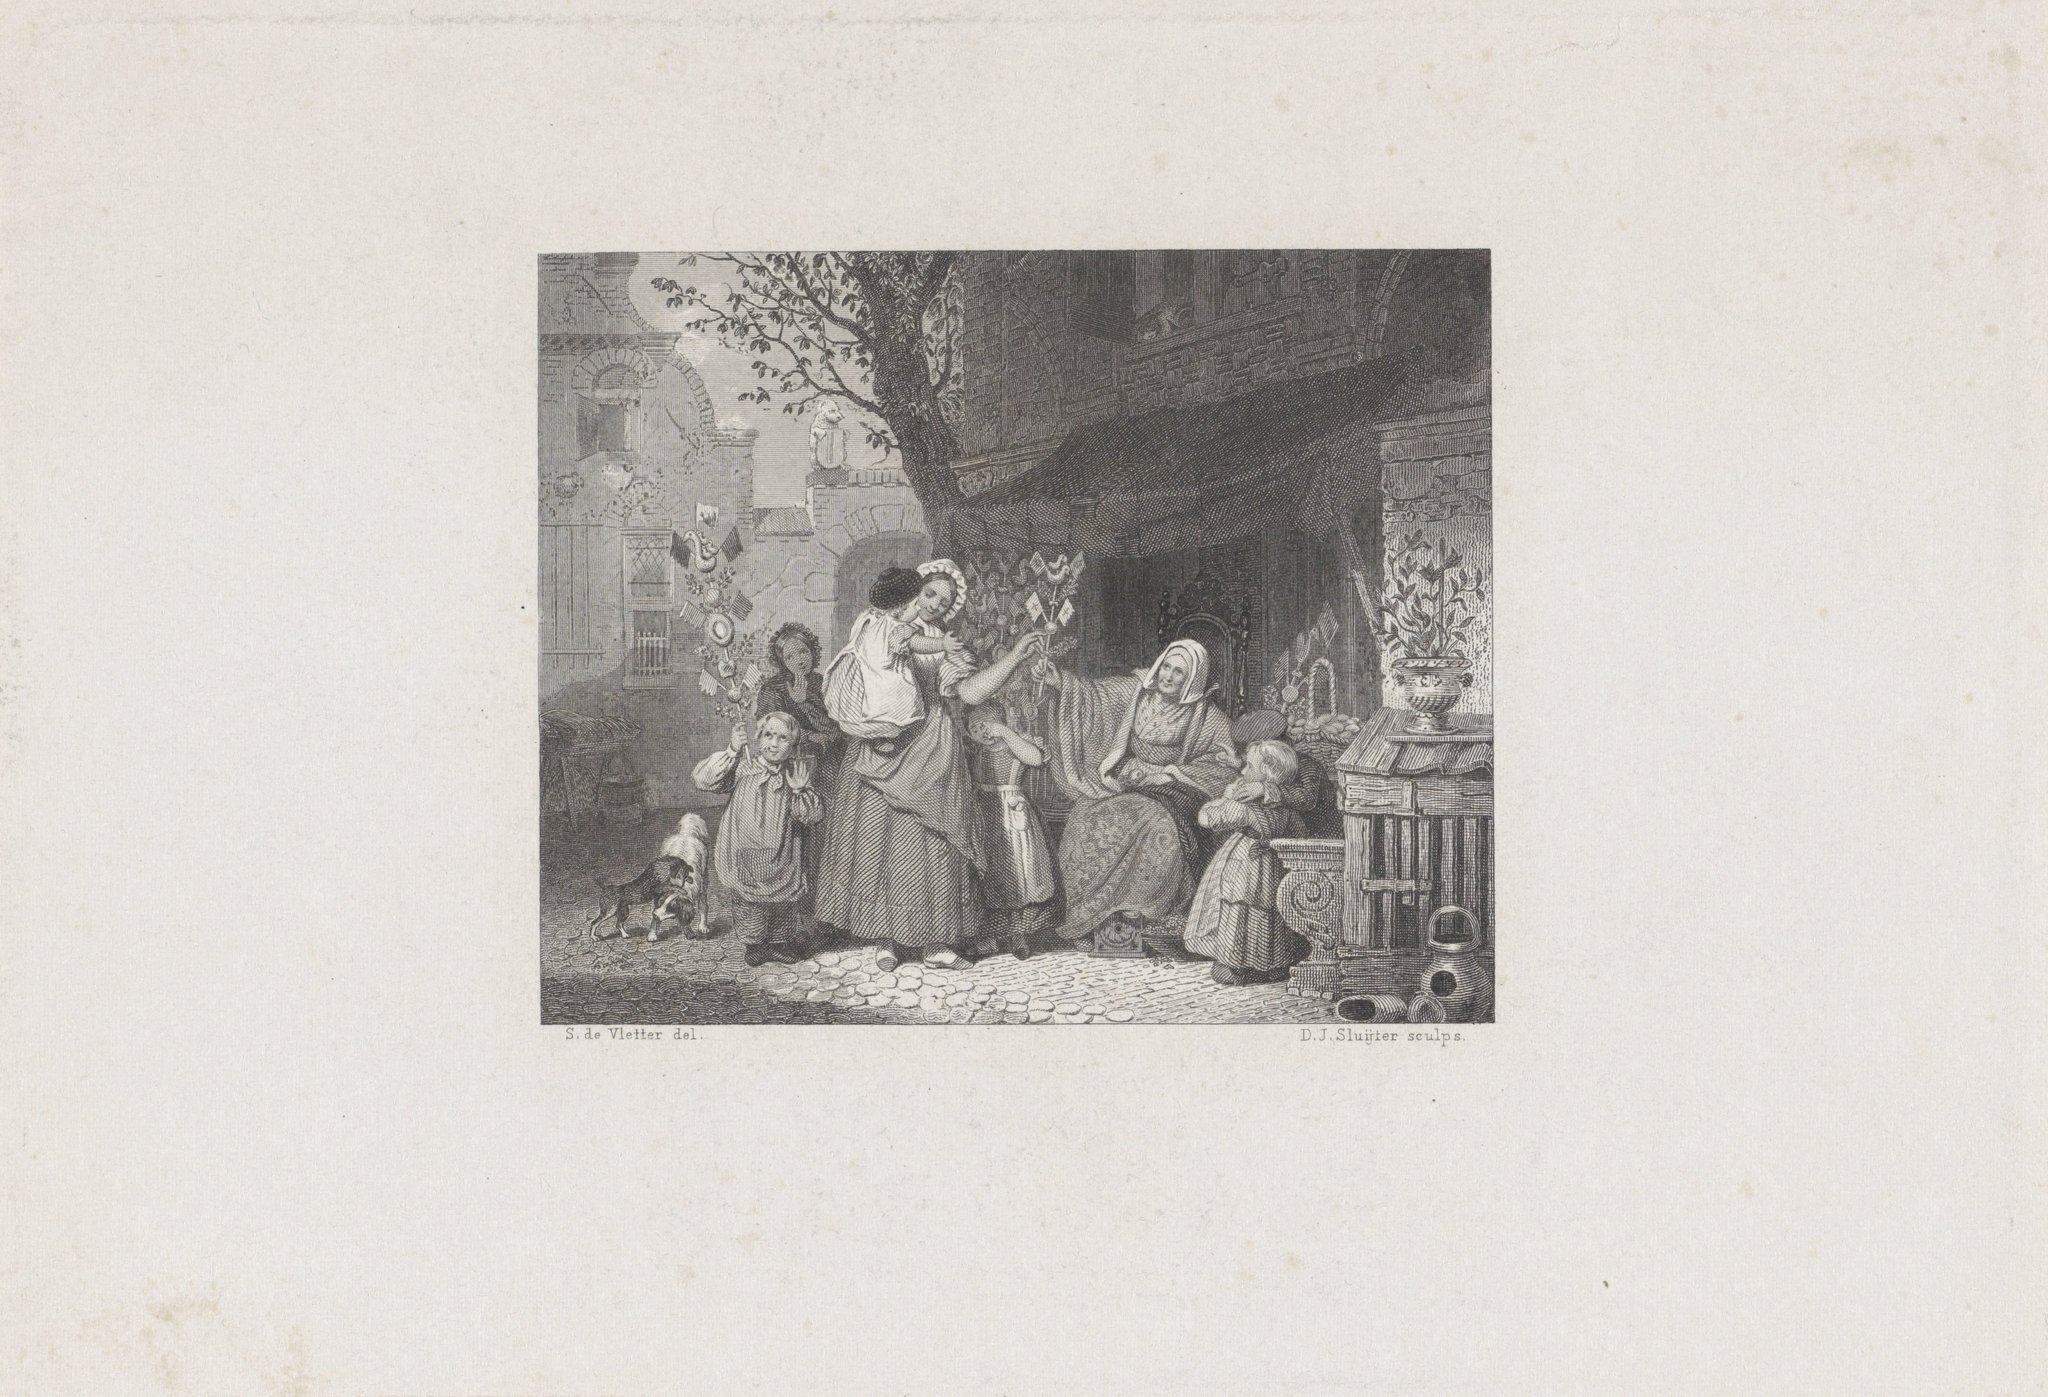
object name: print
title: Palmpasen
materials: paper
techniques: etching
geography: amsterdam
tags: palm sunday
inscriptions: collector's mark: Lugt 2228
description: Een oudere vrouw zit op een rijk bewerkte stoel voor haar huis of winkeltje met stoffen luifel. Zij houdt haar voeten op een stoofje. Zij geeft of verkoopt Palmpasenstokken met broodhaantjes aan de kinderen die zich rondom haar verzamelen. Een moeder wijst een klein kind op haar arm op de versierde stokken. Een groter meisje naast haar staat te huilen. Aan weerszijden van de oudere vrouw staan nog meer stokken uitgestald. Op straat stoeien twee hondjes.